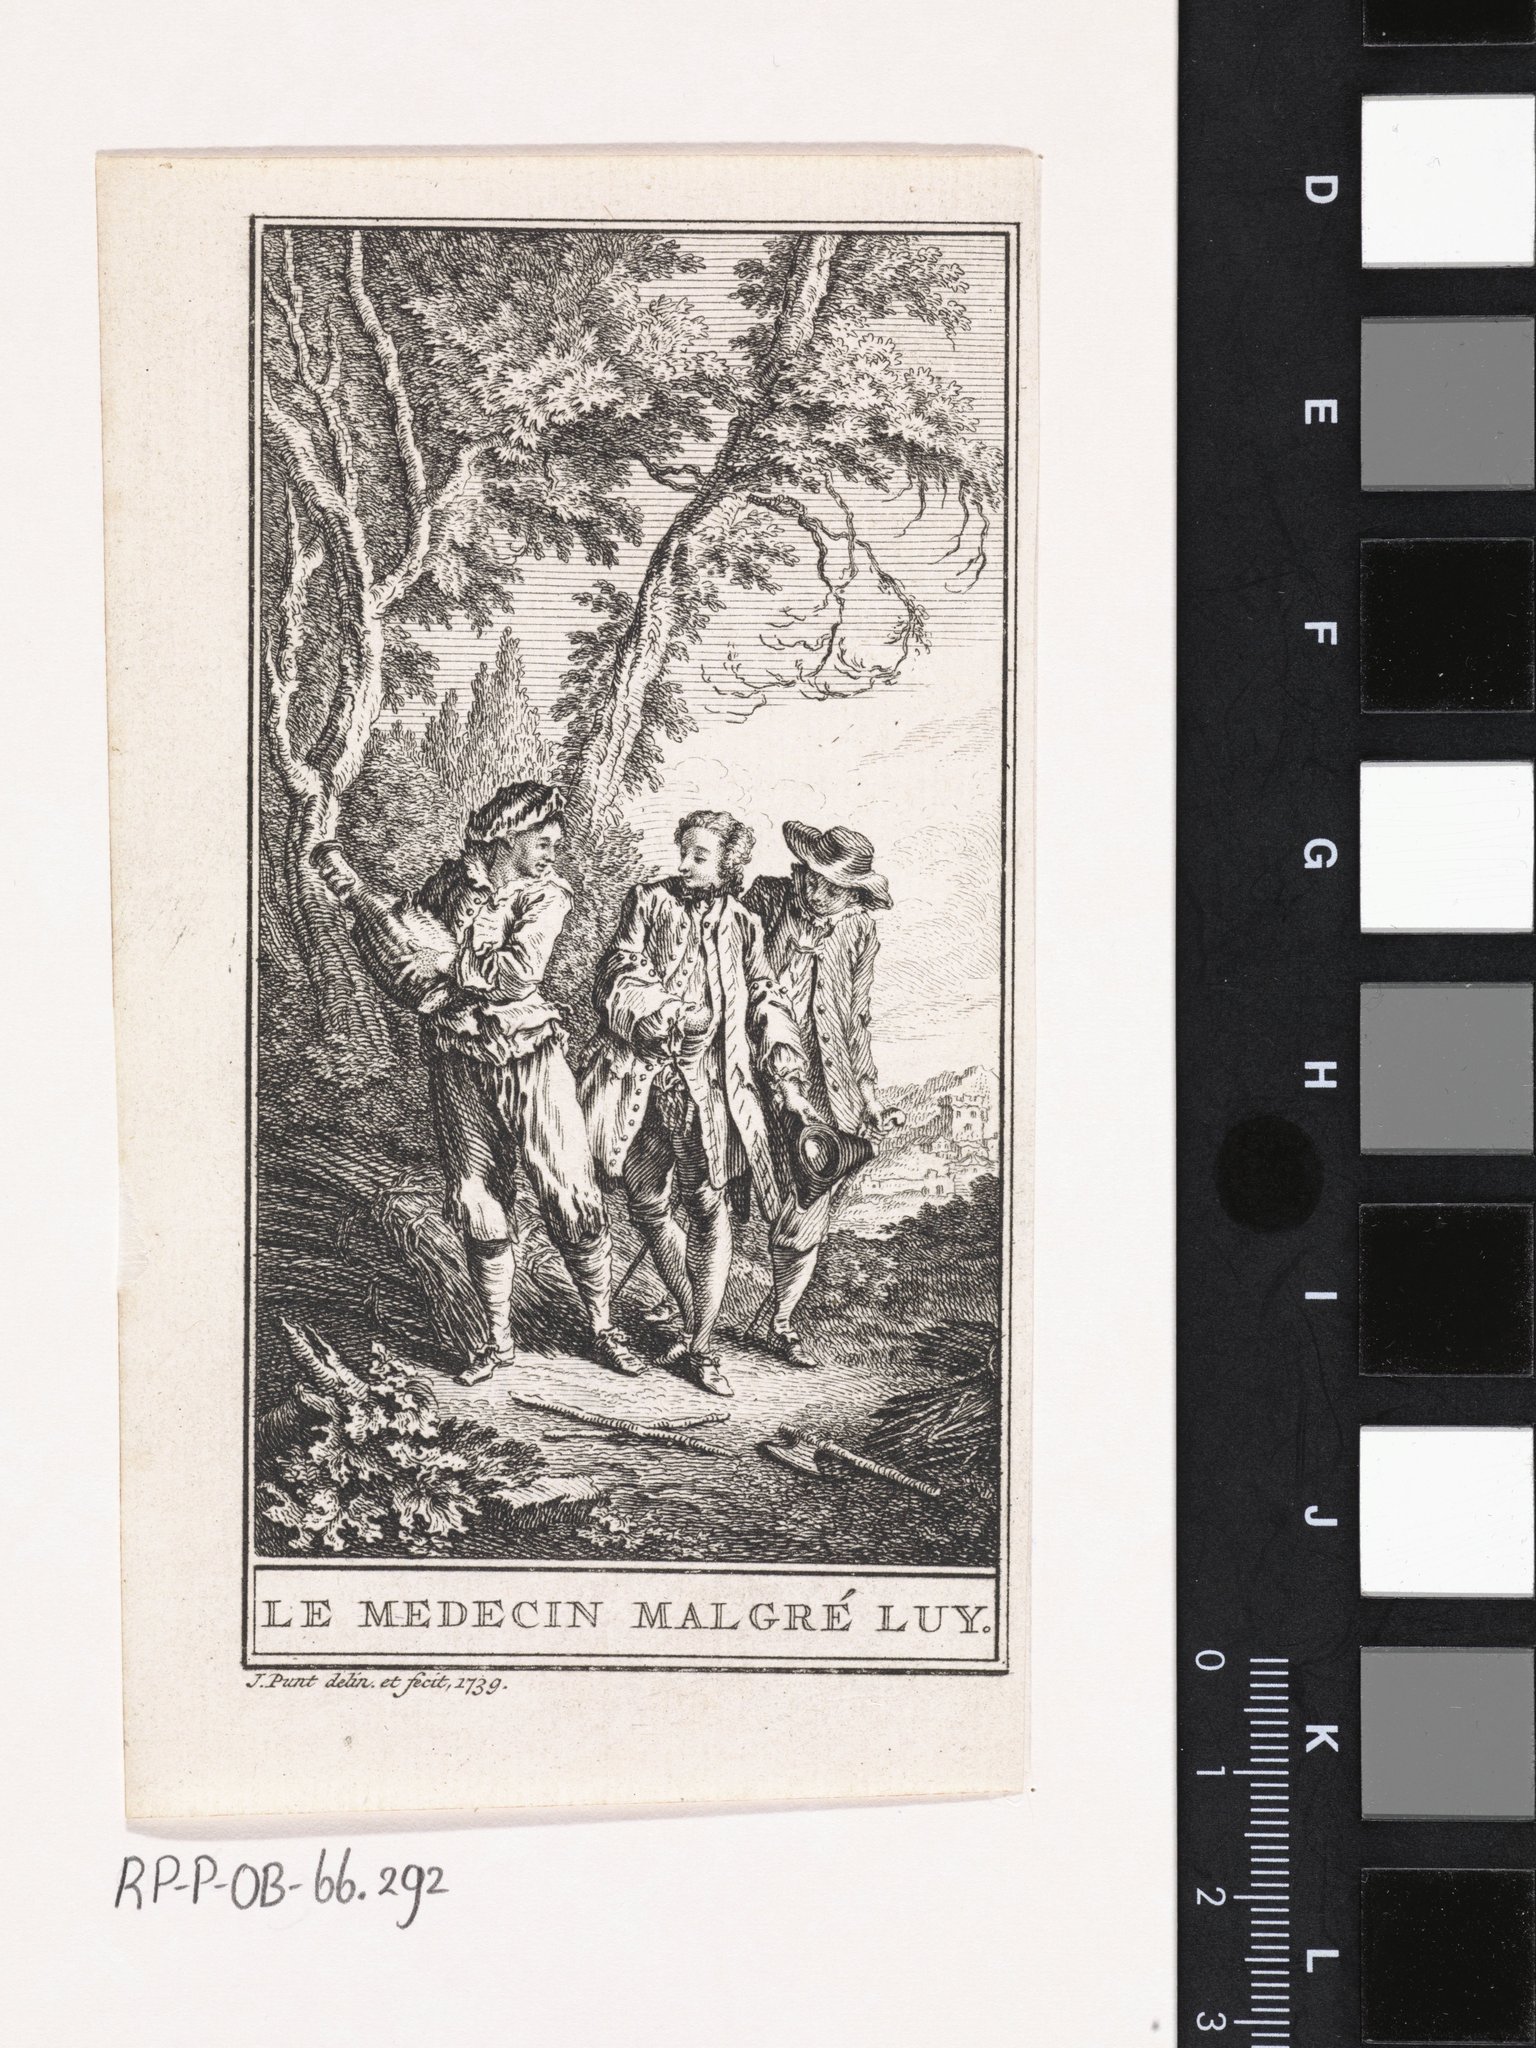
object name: print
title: Drie mannen in het bos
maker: jan punt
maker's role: draughtsman, print maker, publisher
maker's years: 1711-1779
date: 1739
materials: paper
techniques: engraving, etching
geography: amsterdam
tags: (moliere) specific works of literature (with author, title), forest, wood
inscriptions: collector's mark: Lugt 2228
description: Drie mannen wandelen over een pad door het bos. Degene die voorop loopt draagt een kruik. Scène uit het toneelstuk Le Médecin malgré lui (Dokter tegen wil en dank), van Molière.